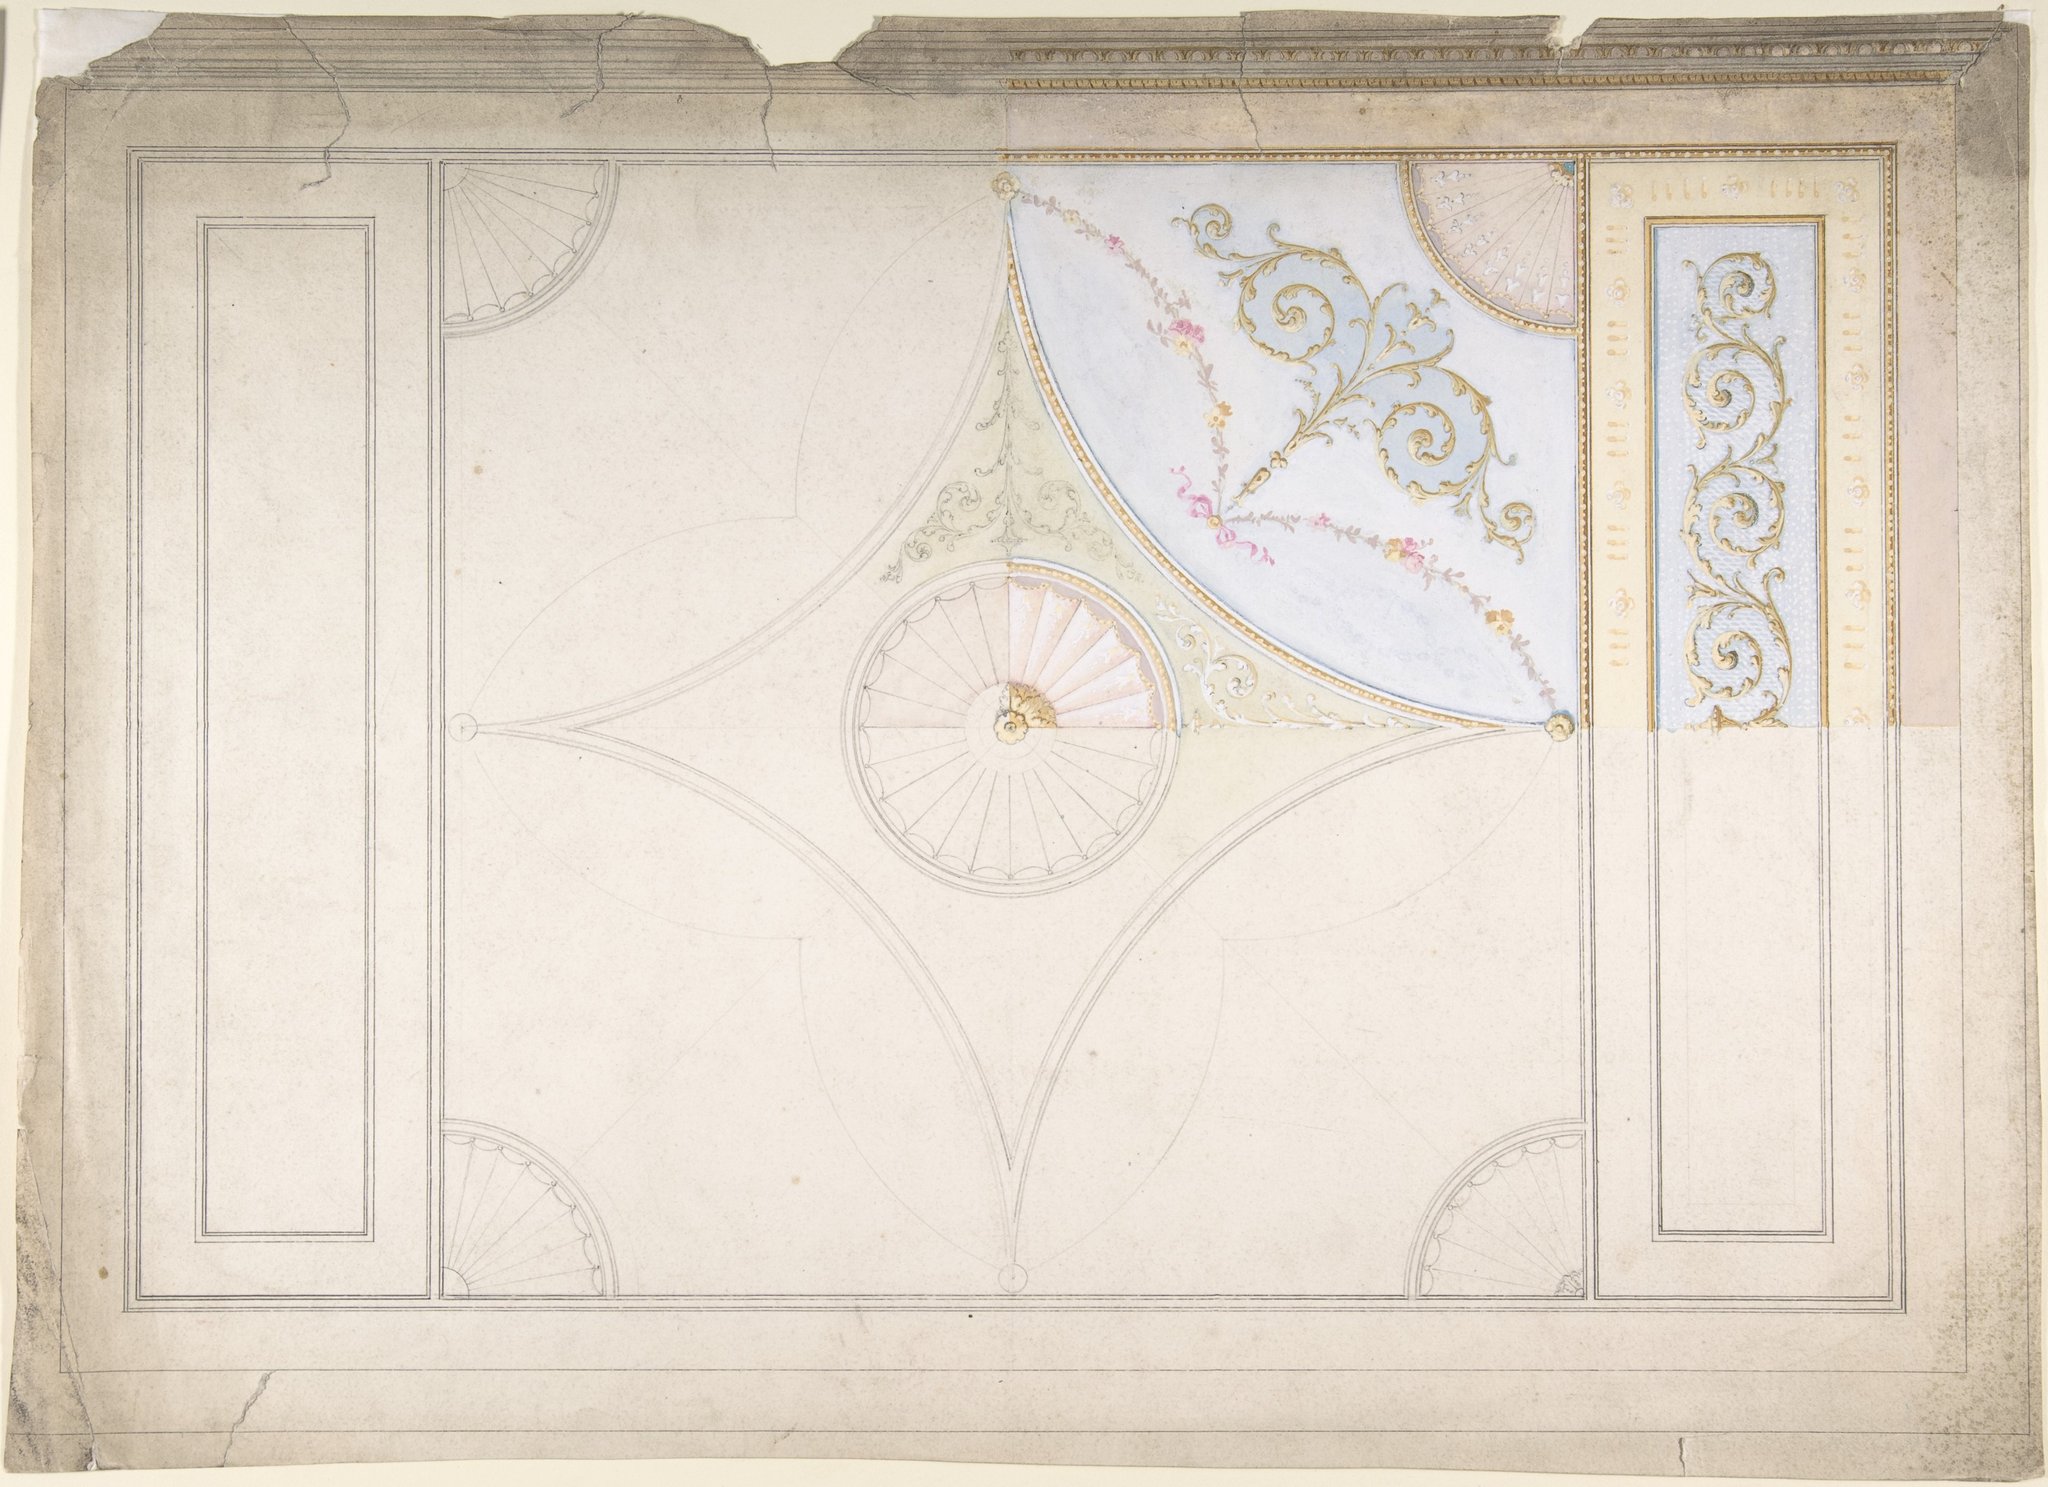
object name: drawing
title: Ceiling Design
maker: anonymous, british, 19th century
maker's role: artist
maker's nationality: british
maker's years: 1800-1900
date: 1867-1900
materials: ink, watercolor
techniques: pen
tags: architecture,ceilings